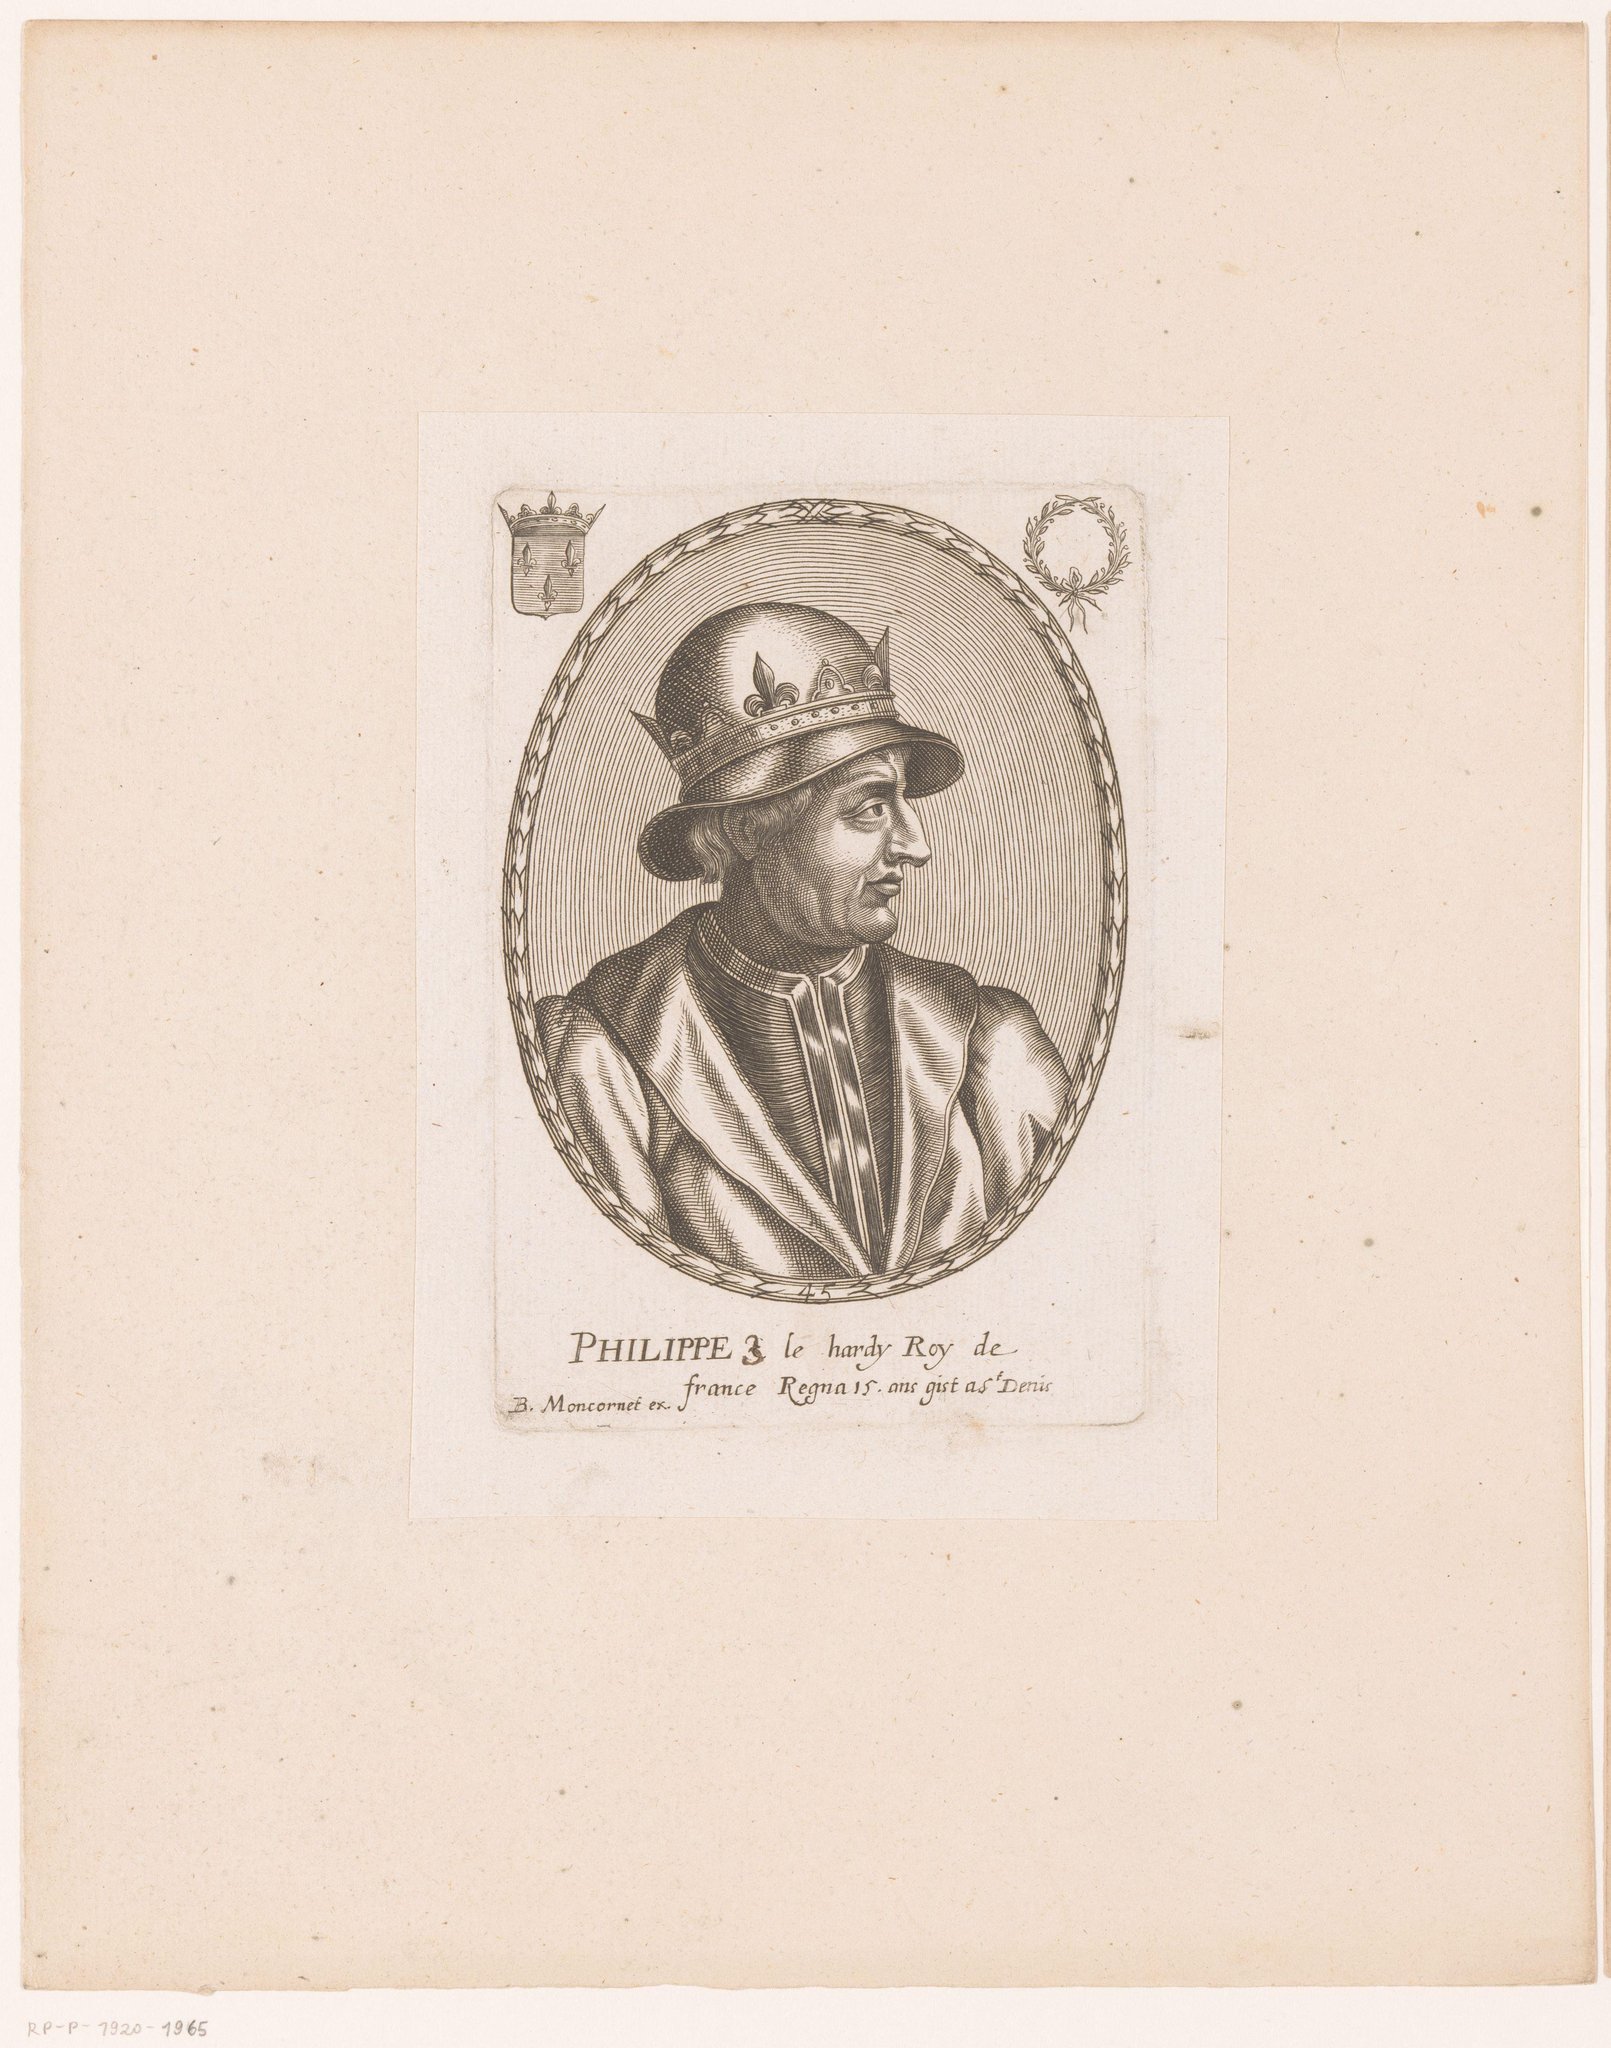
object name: print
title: Portret van Filips III van Frankrijk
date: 1610-1668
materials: paper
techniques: engraving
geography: paris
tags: historical persons, king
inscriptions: collector's mark: Lugt 2228